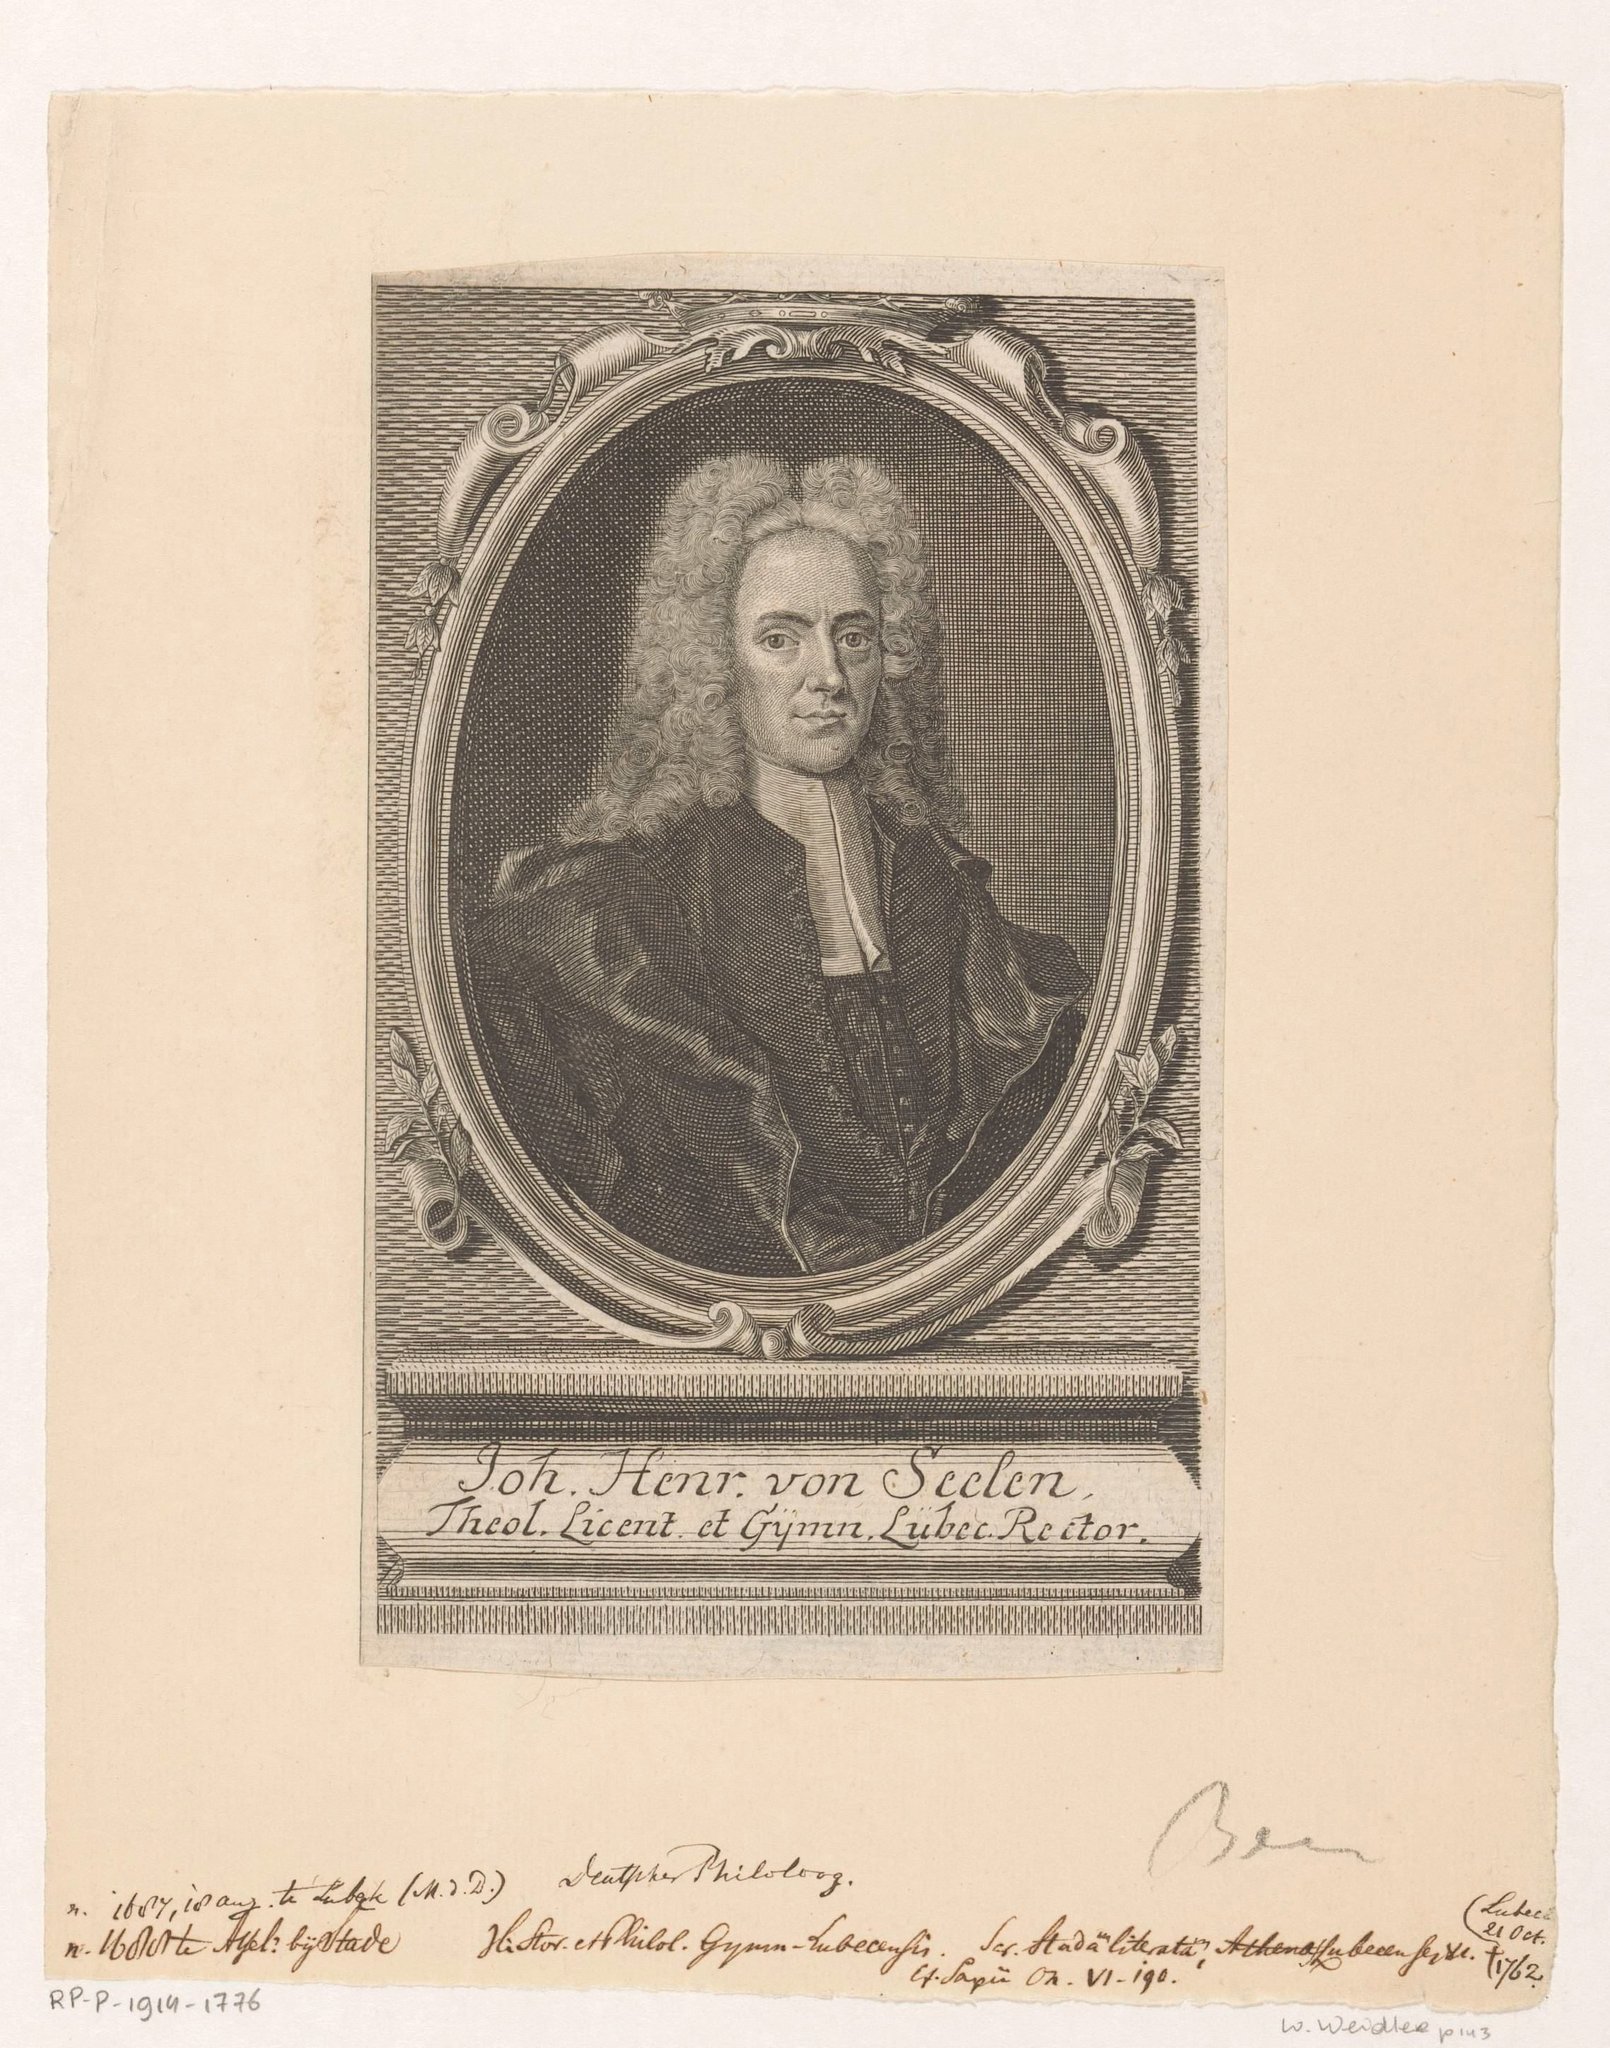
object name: print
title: Portret van Johann Heinrich von Seelen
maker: martin bernigeroth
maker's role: print maker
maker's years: 1670-1733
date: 1728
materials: paper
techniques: engraving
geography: leipzig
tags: johann heinrich von seelen, historical persons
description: Prent ook gebruikt in: Deutsche Acta Eruditorum (...). dl. 136. Leipzig: Johann Gottlieb Gleditsch, 1728.